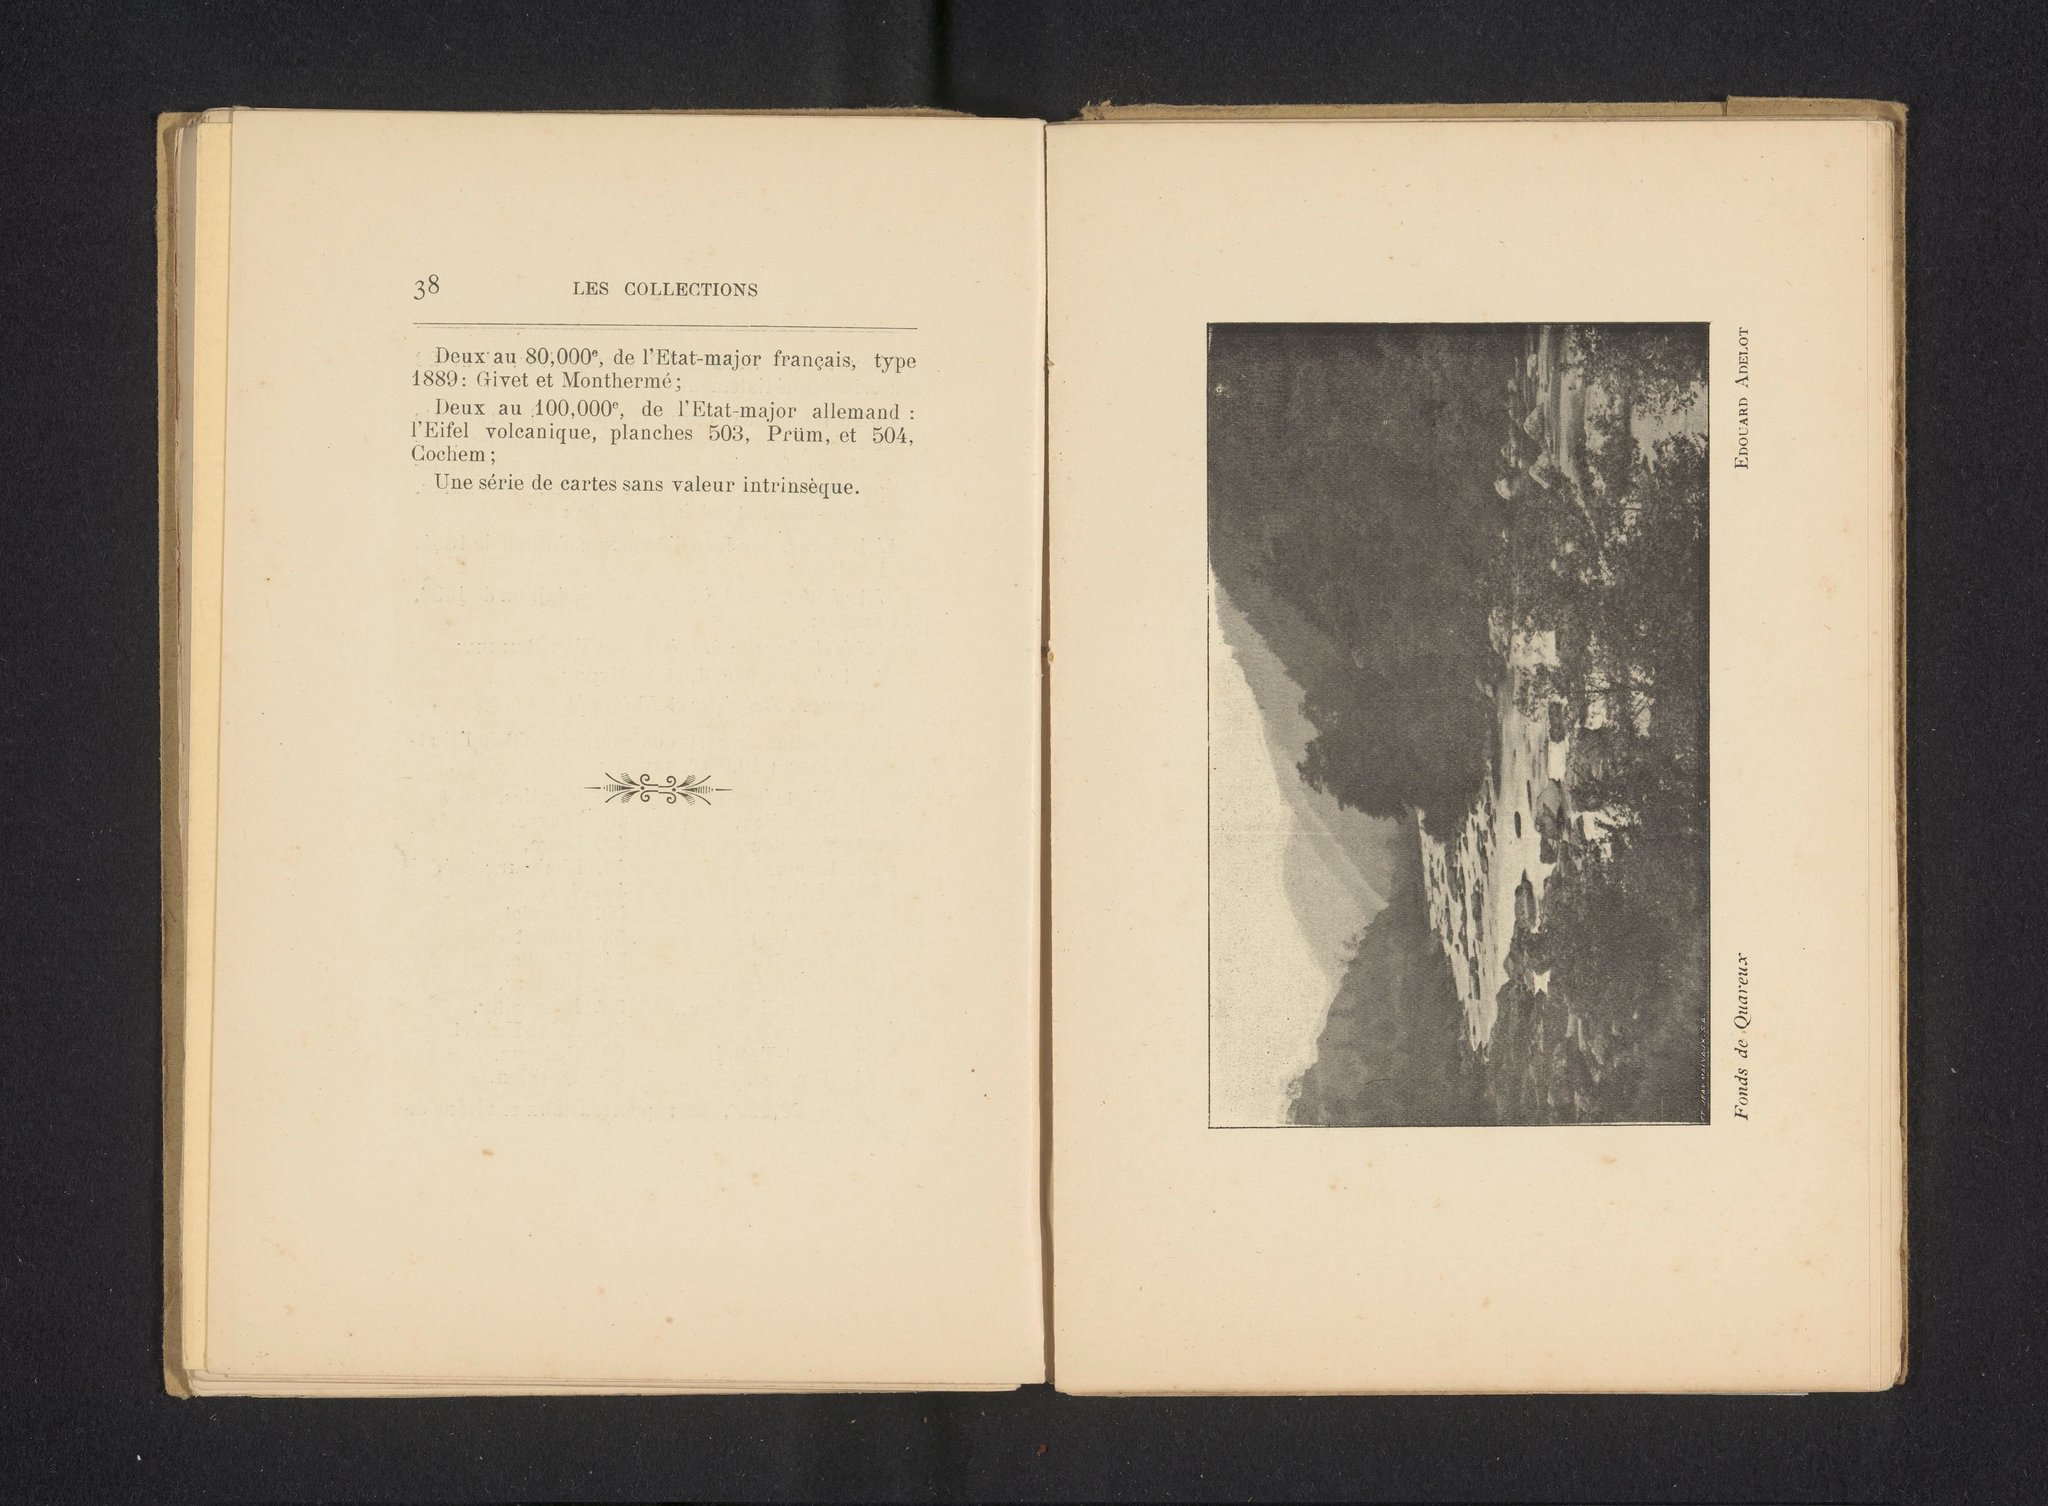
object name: page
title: Fonds de Quareux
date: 1896-1901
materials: paper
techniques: autotype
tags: dale, valley, river